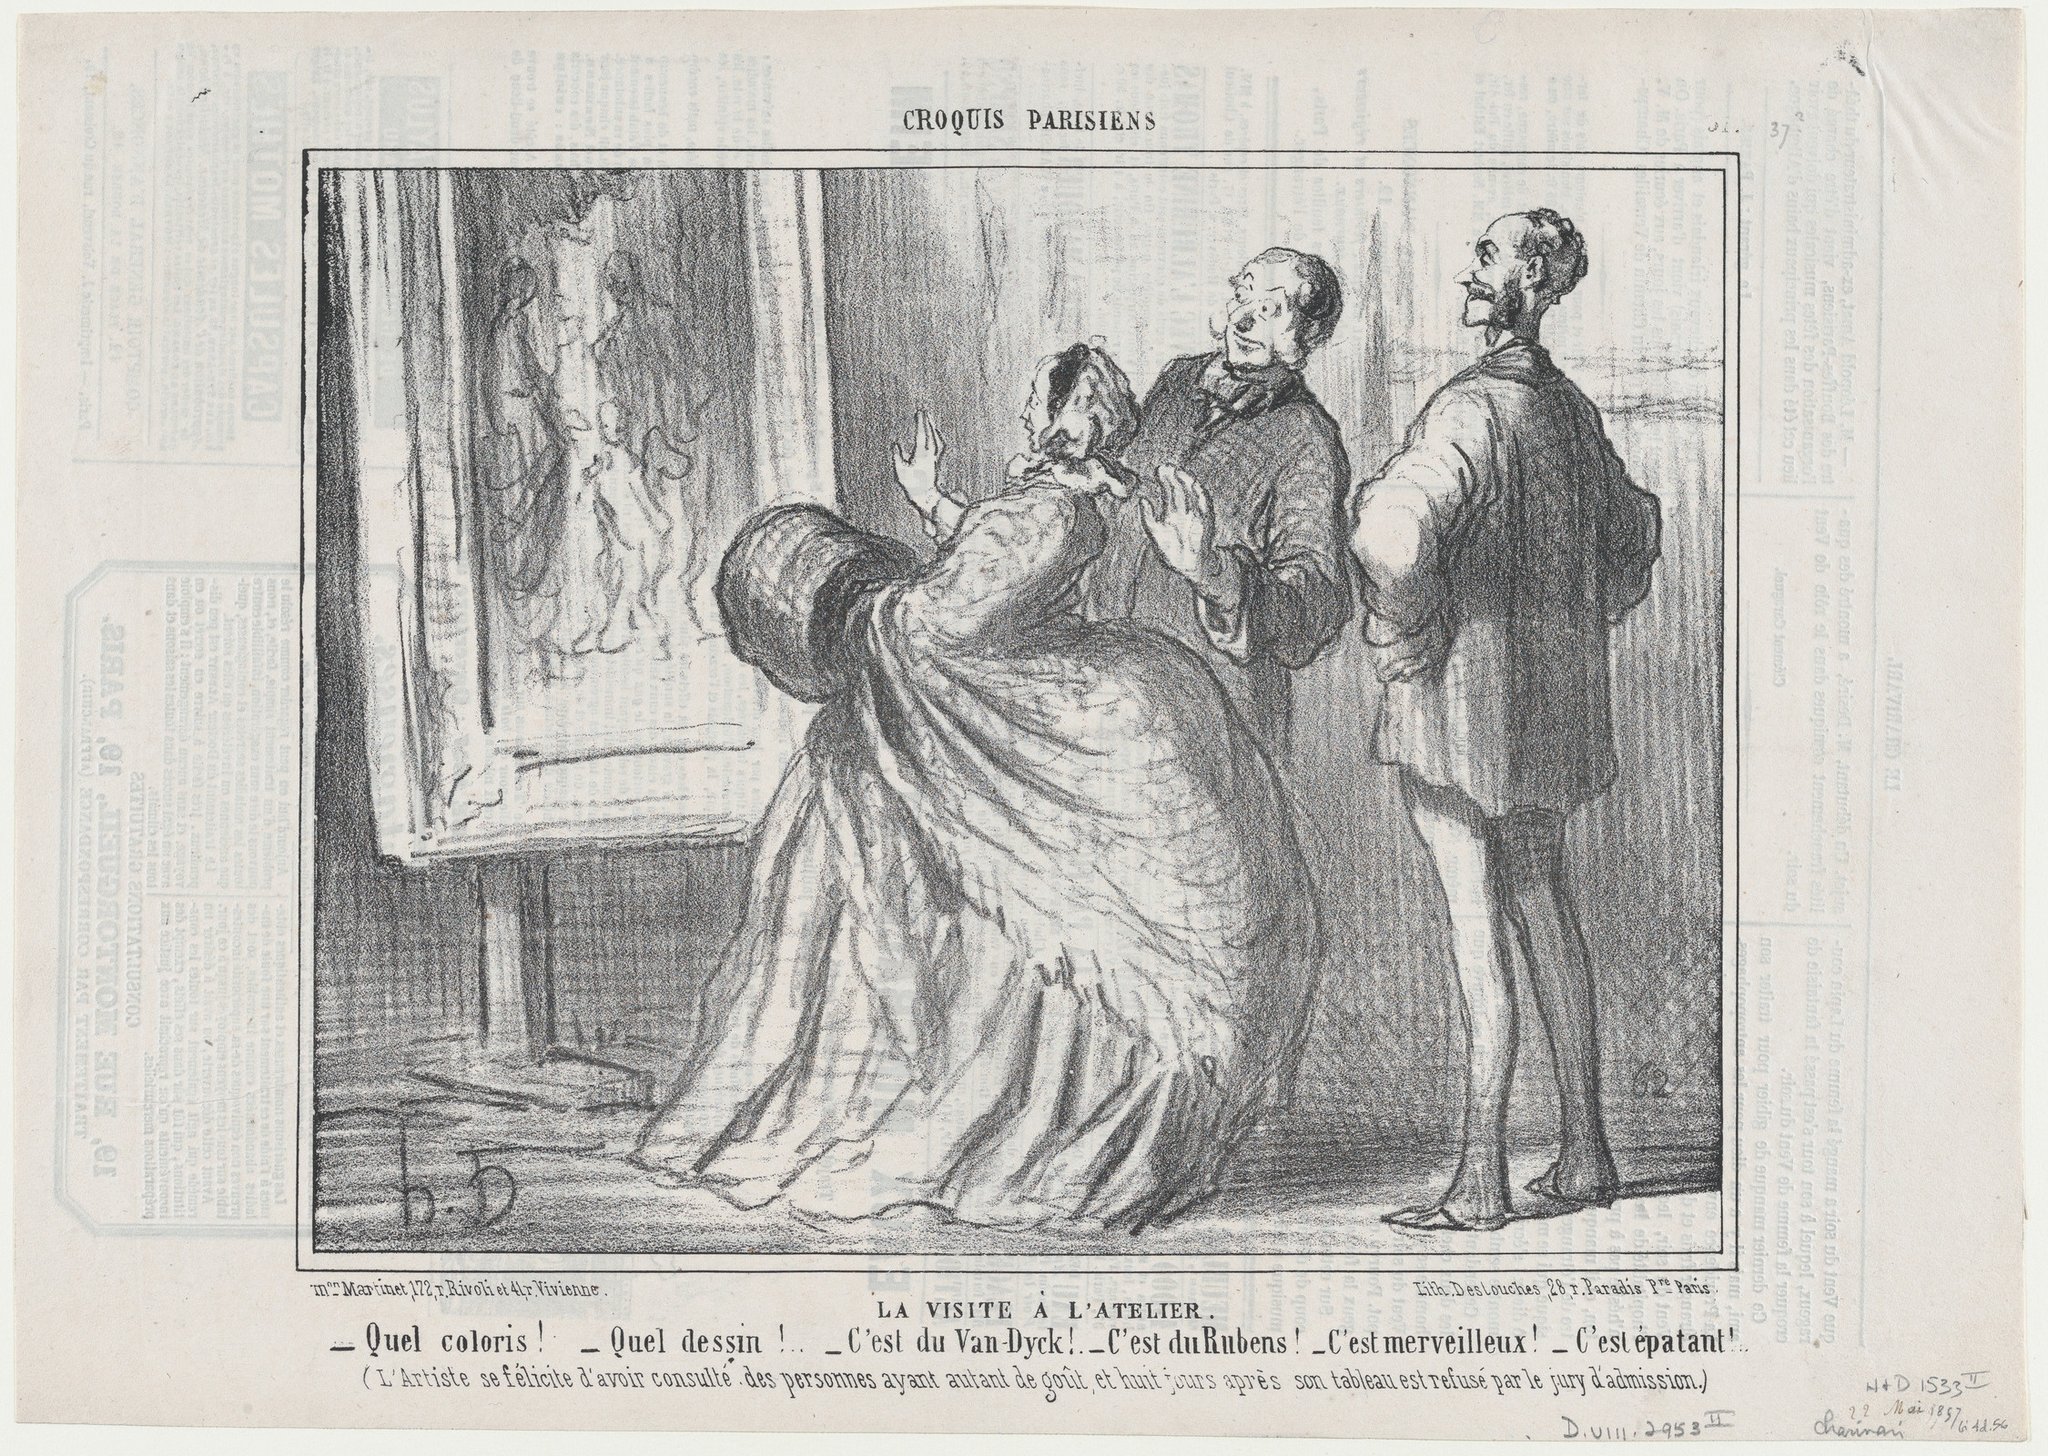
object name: print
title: La Visite à l'Atelier, from Croquis Parisiens, published in Le Charivari, May 22, 1857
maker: honoré daumier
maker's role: artist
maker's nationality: french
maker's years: 1808-1879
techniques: lithograph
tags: men,women